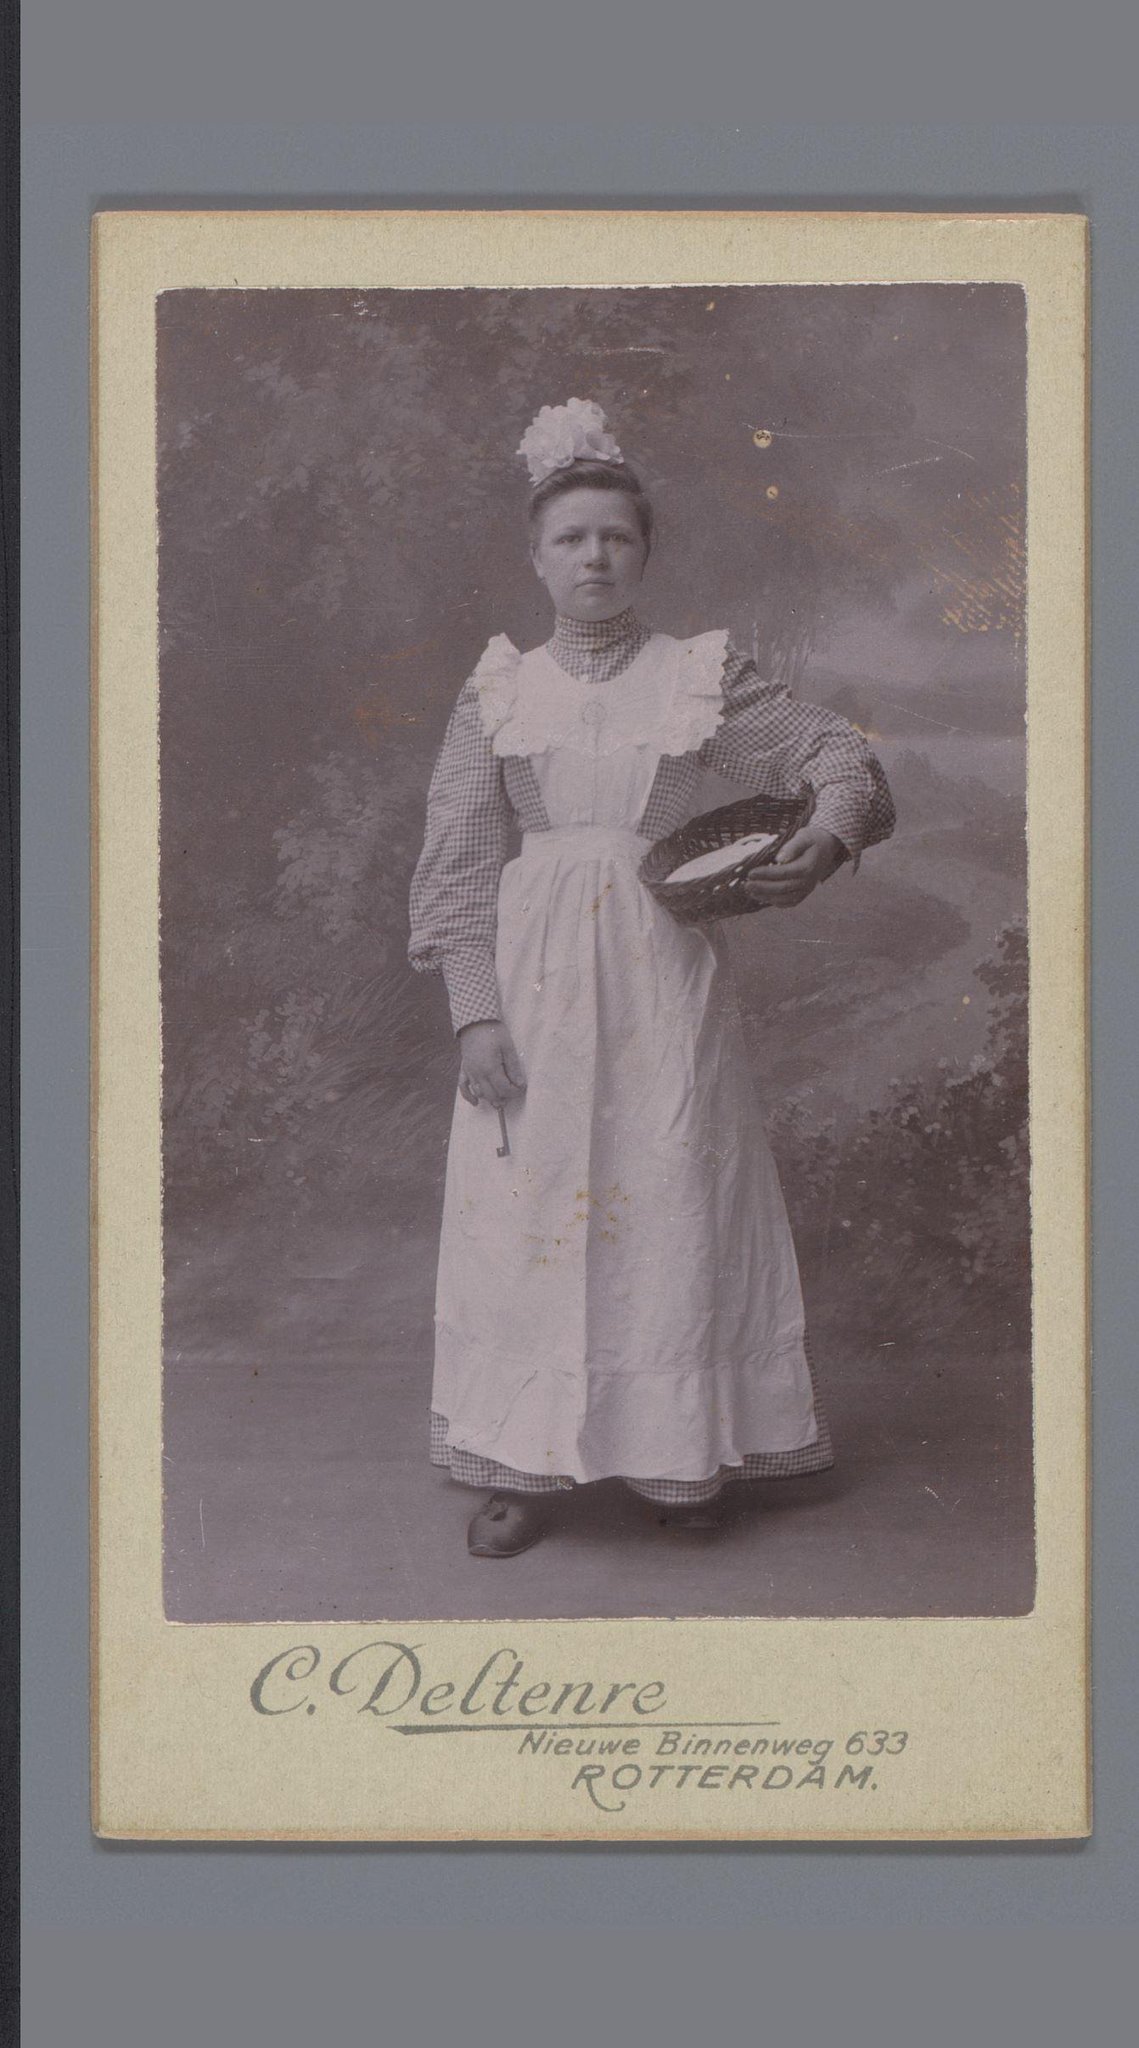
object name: photograph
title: Carte-de-visite Portraits of Domestic Workers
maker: cornelis deltenre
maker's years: 1854-1933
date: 1900-1909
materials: paper, cardboard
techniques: collodion silver print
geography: rotterdam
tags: adolescent, young woman, maiden, anonymous historical person portrayed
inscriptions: address: ‘Nieuwe Binnenweg/ 633/ over de Remise/ Rotterdam’, inscription: ‘SPECIALITEIT IN VERGROOTINGEN./ OLIEVERF PORTRETTEN EN REPRODUCTIES/ NAAR IEDER PORTRET. GROEPEN EN BUITENOPNAMEN.’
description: The woman in the upper left photograph is Lina Hamming, a domestic worker in Amsterdam. Hamming was one of thousands of women who worked in the households of wealthy families. We do not know the names of the other women, but we do know their occupation: domestic workers. They wore the characteristic white aprons and caps. The baskets and the dustpan and brush indicate their duties in the household.